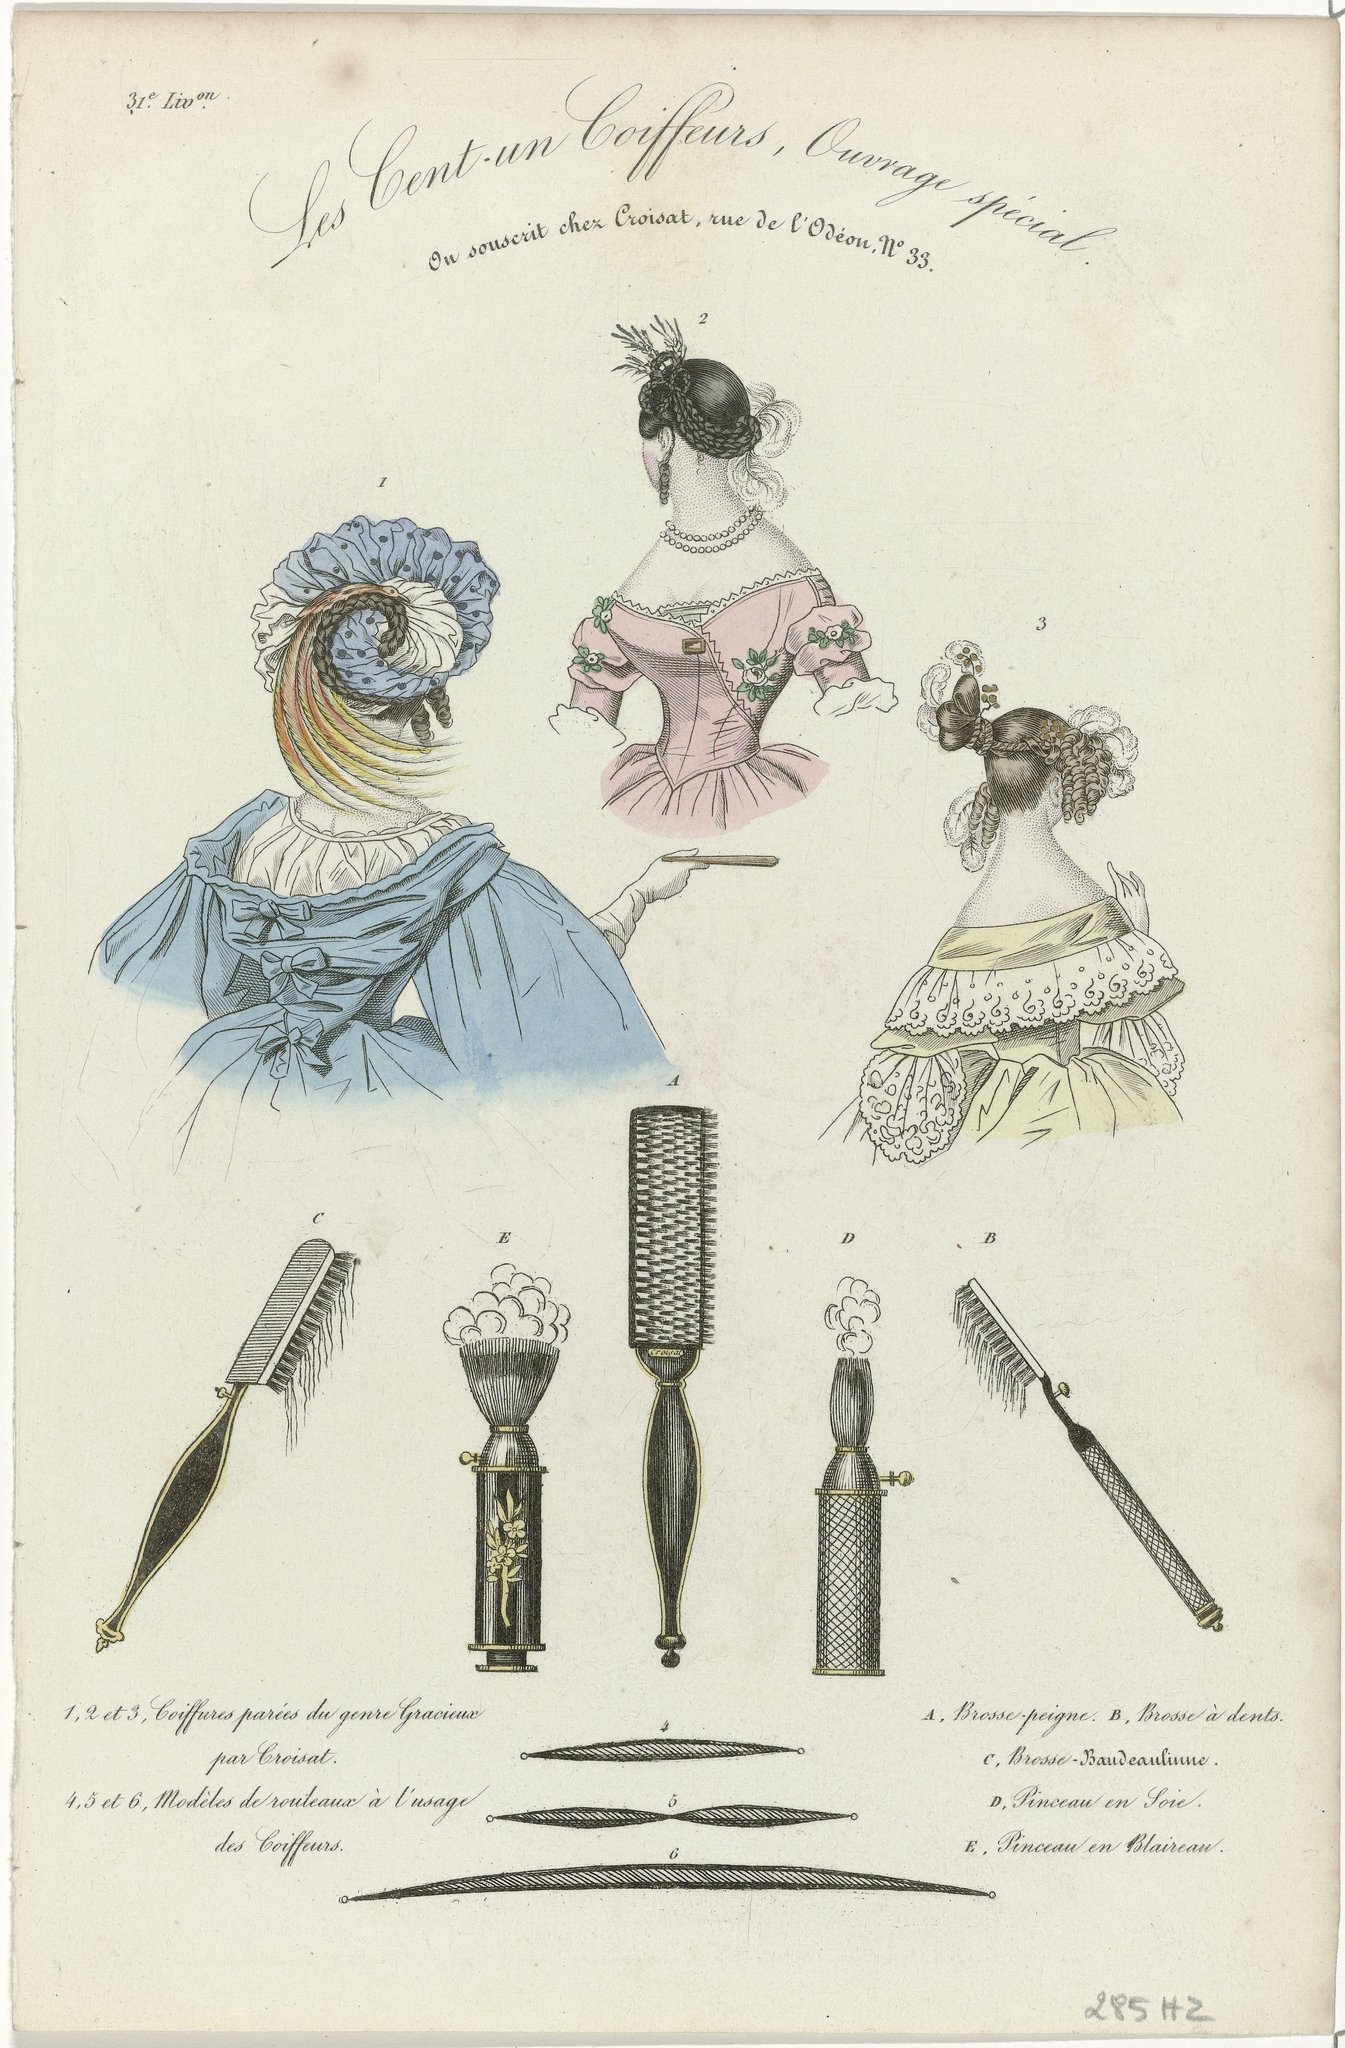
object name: fashion print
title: Les Cent-un Coiffeurs, Ouvrage spécial, 1836-1841, 31e liv. , No. 31: 1,2 et 3, Coiffures parées (...)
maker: Anonymous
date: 1836-1841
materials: paper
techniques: engraving, hand coloring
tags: head-gear (+ women's clothes), styles of hairdress - aa - ~ women, comb, brush and other tools (care of the hair) - aa - ~ women, fashion plates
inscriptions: title: ‘Les Cent-un Coiffeurs, Ouvrage spécial.’, address: ‘On souscrit chez croisat, rue de l'Odéon, No 33.’, caption: ‘A, Brosse-peigne. B, Brosse à dents. C, Brosse-Baudeaulinne. D, Pinceau en Soie. E, Pinceau en Blaireau.’, caption: ‘1,2 et 3, Coiffures parées du genre Gracieux par Croisat. 4,5 et 6, Modèles de rouleaux à l'usage des Coiffeurs.’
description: 1,2 en 3 : 'coiffures',van Croisat. 4,5 en 6: modellen 'rouleaux'. Kappersbenodigdheden: A, haarborstel. B, tandenborstel. C, borstel - 'baudeaulinne'. D, kwast van zijde. E, scheerkwast. Prent uit het modetijdschrift Les Cent-un Coiffeurs (1836-1841).